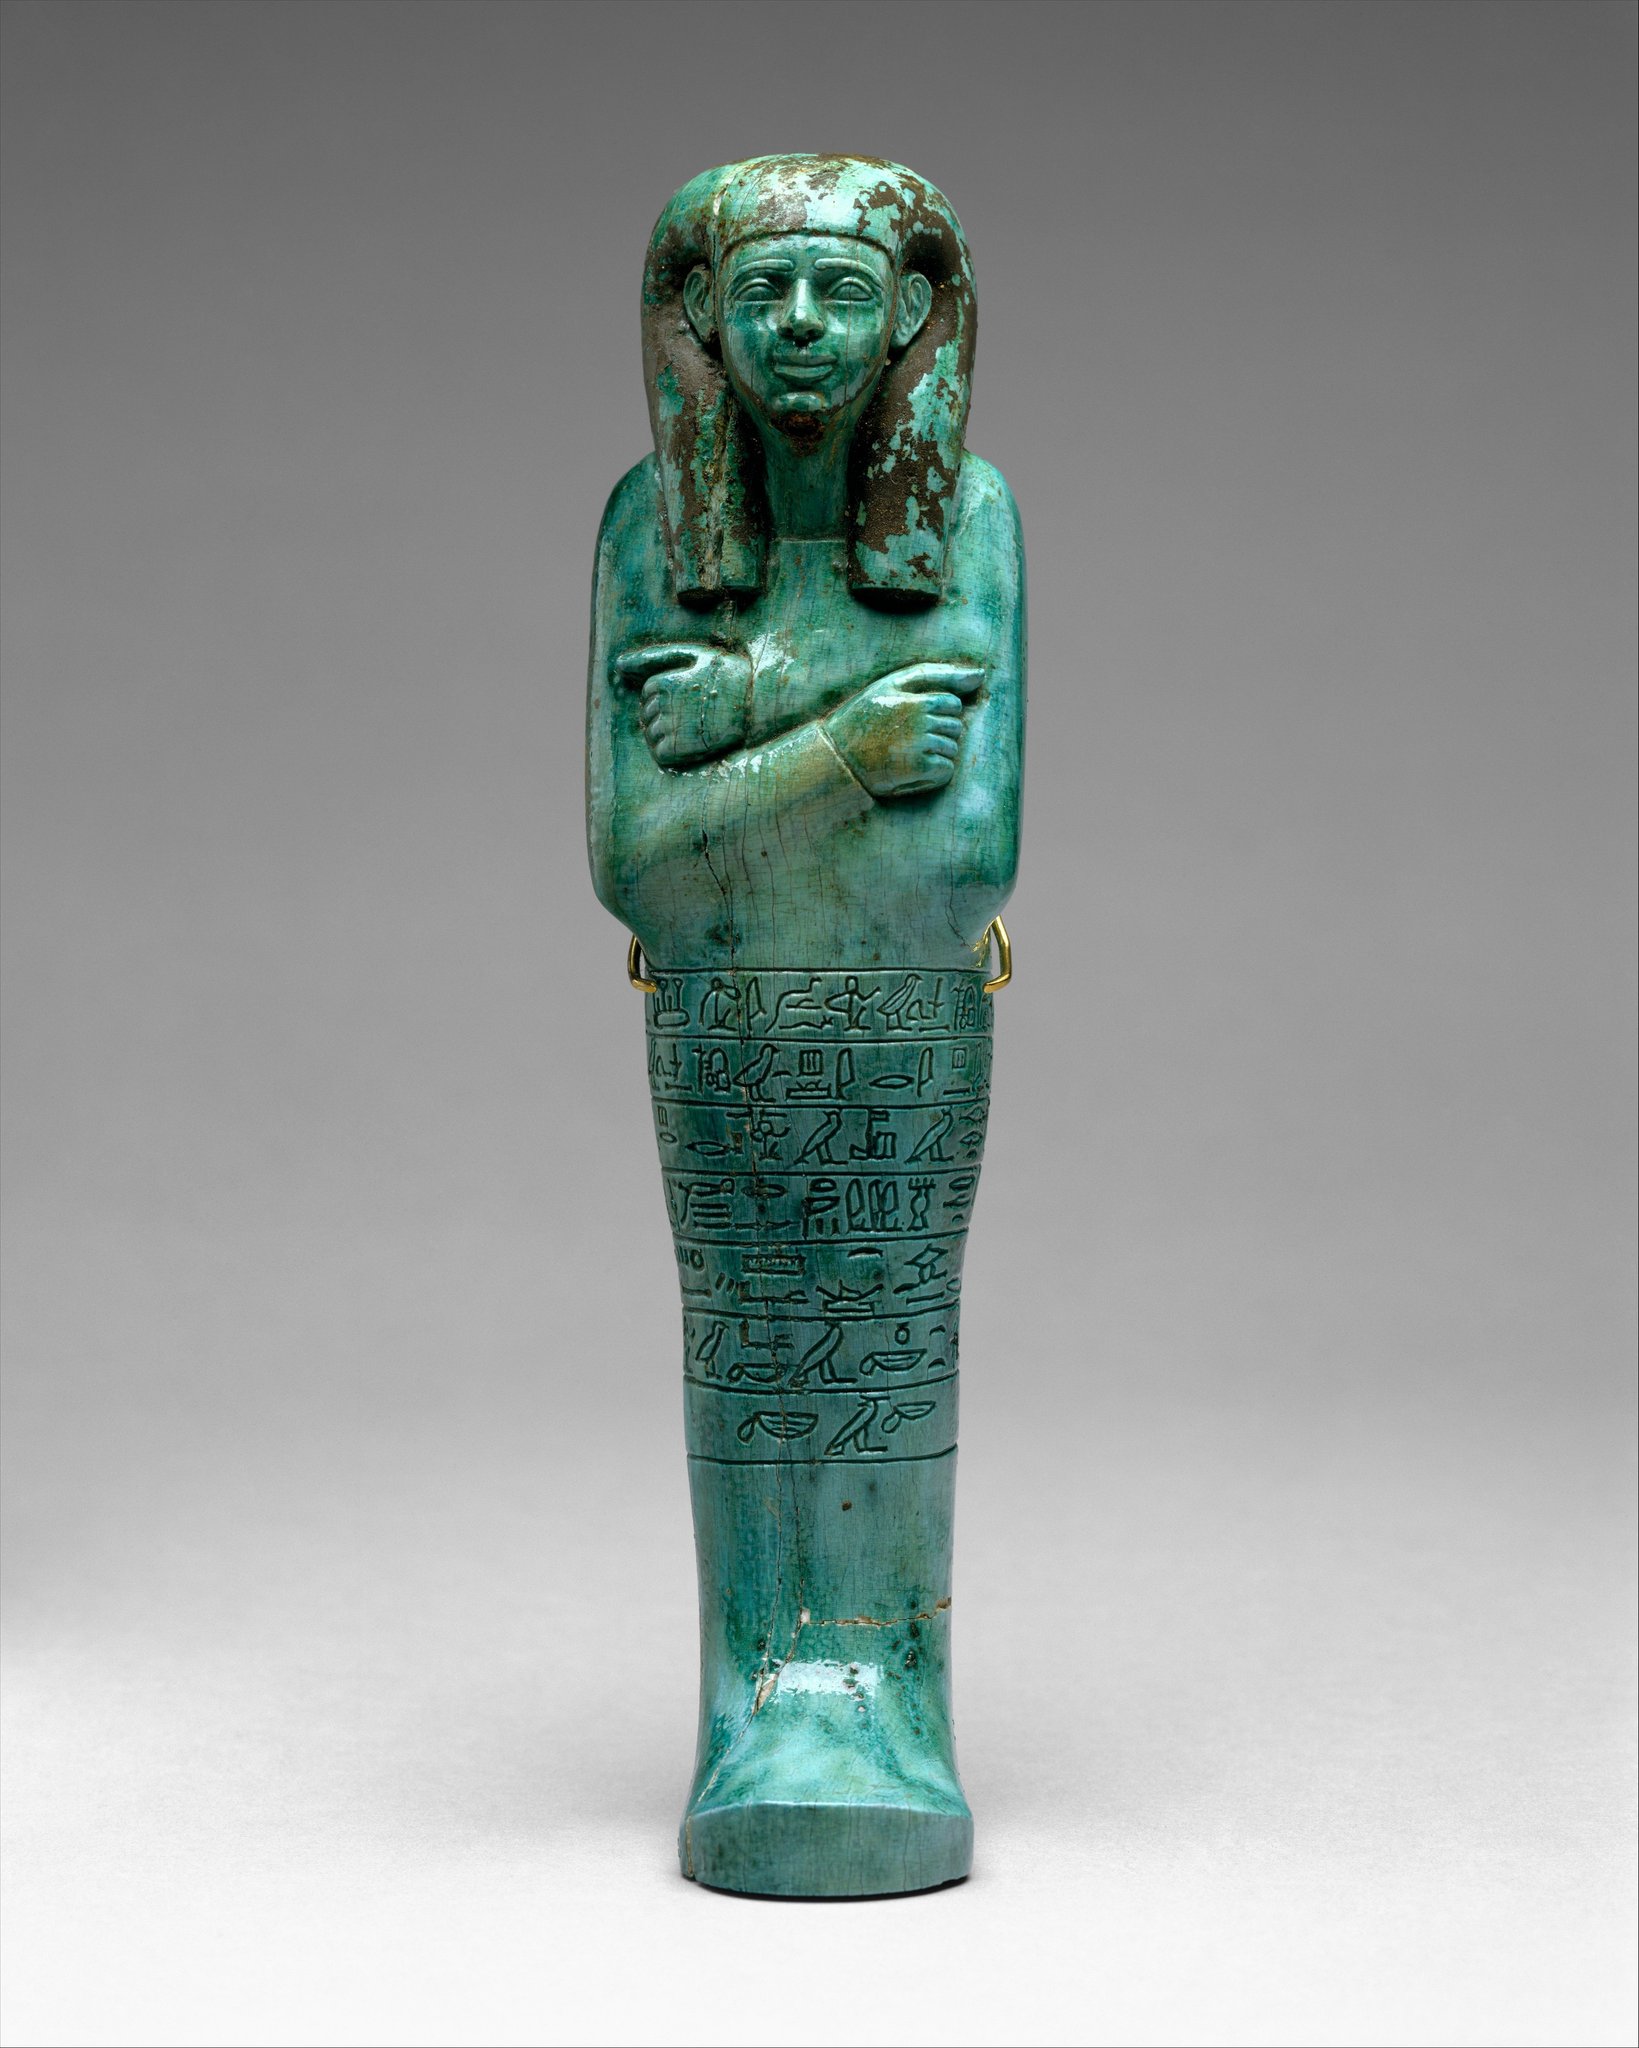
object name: shabti, seniu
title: Shabti of Seniu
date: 1525-1504 BCE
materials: paint, stone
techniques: glazing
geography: egypt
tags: hieroglyphs